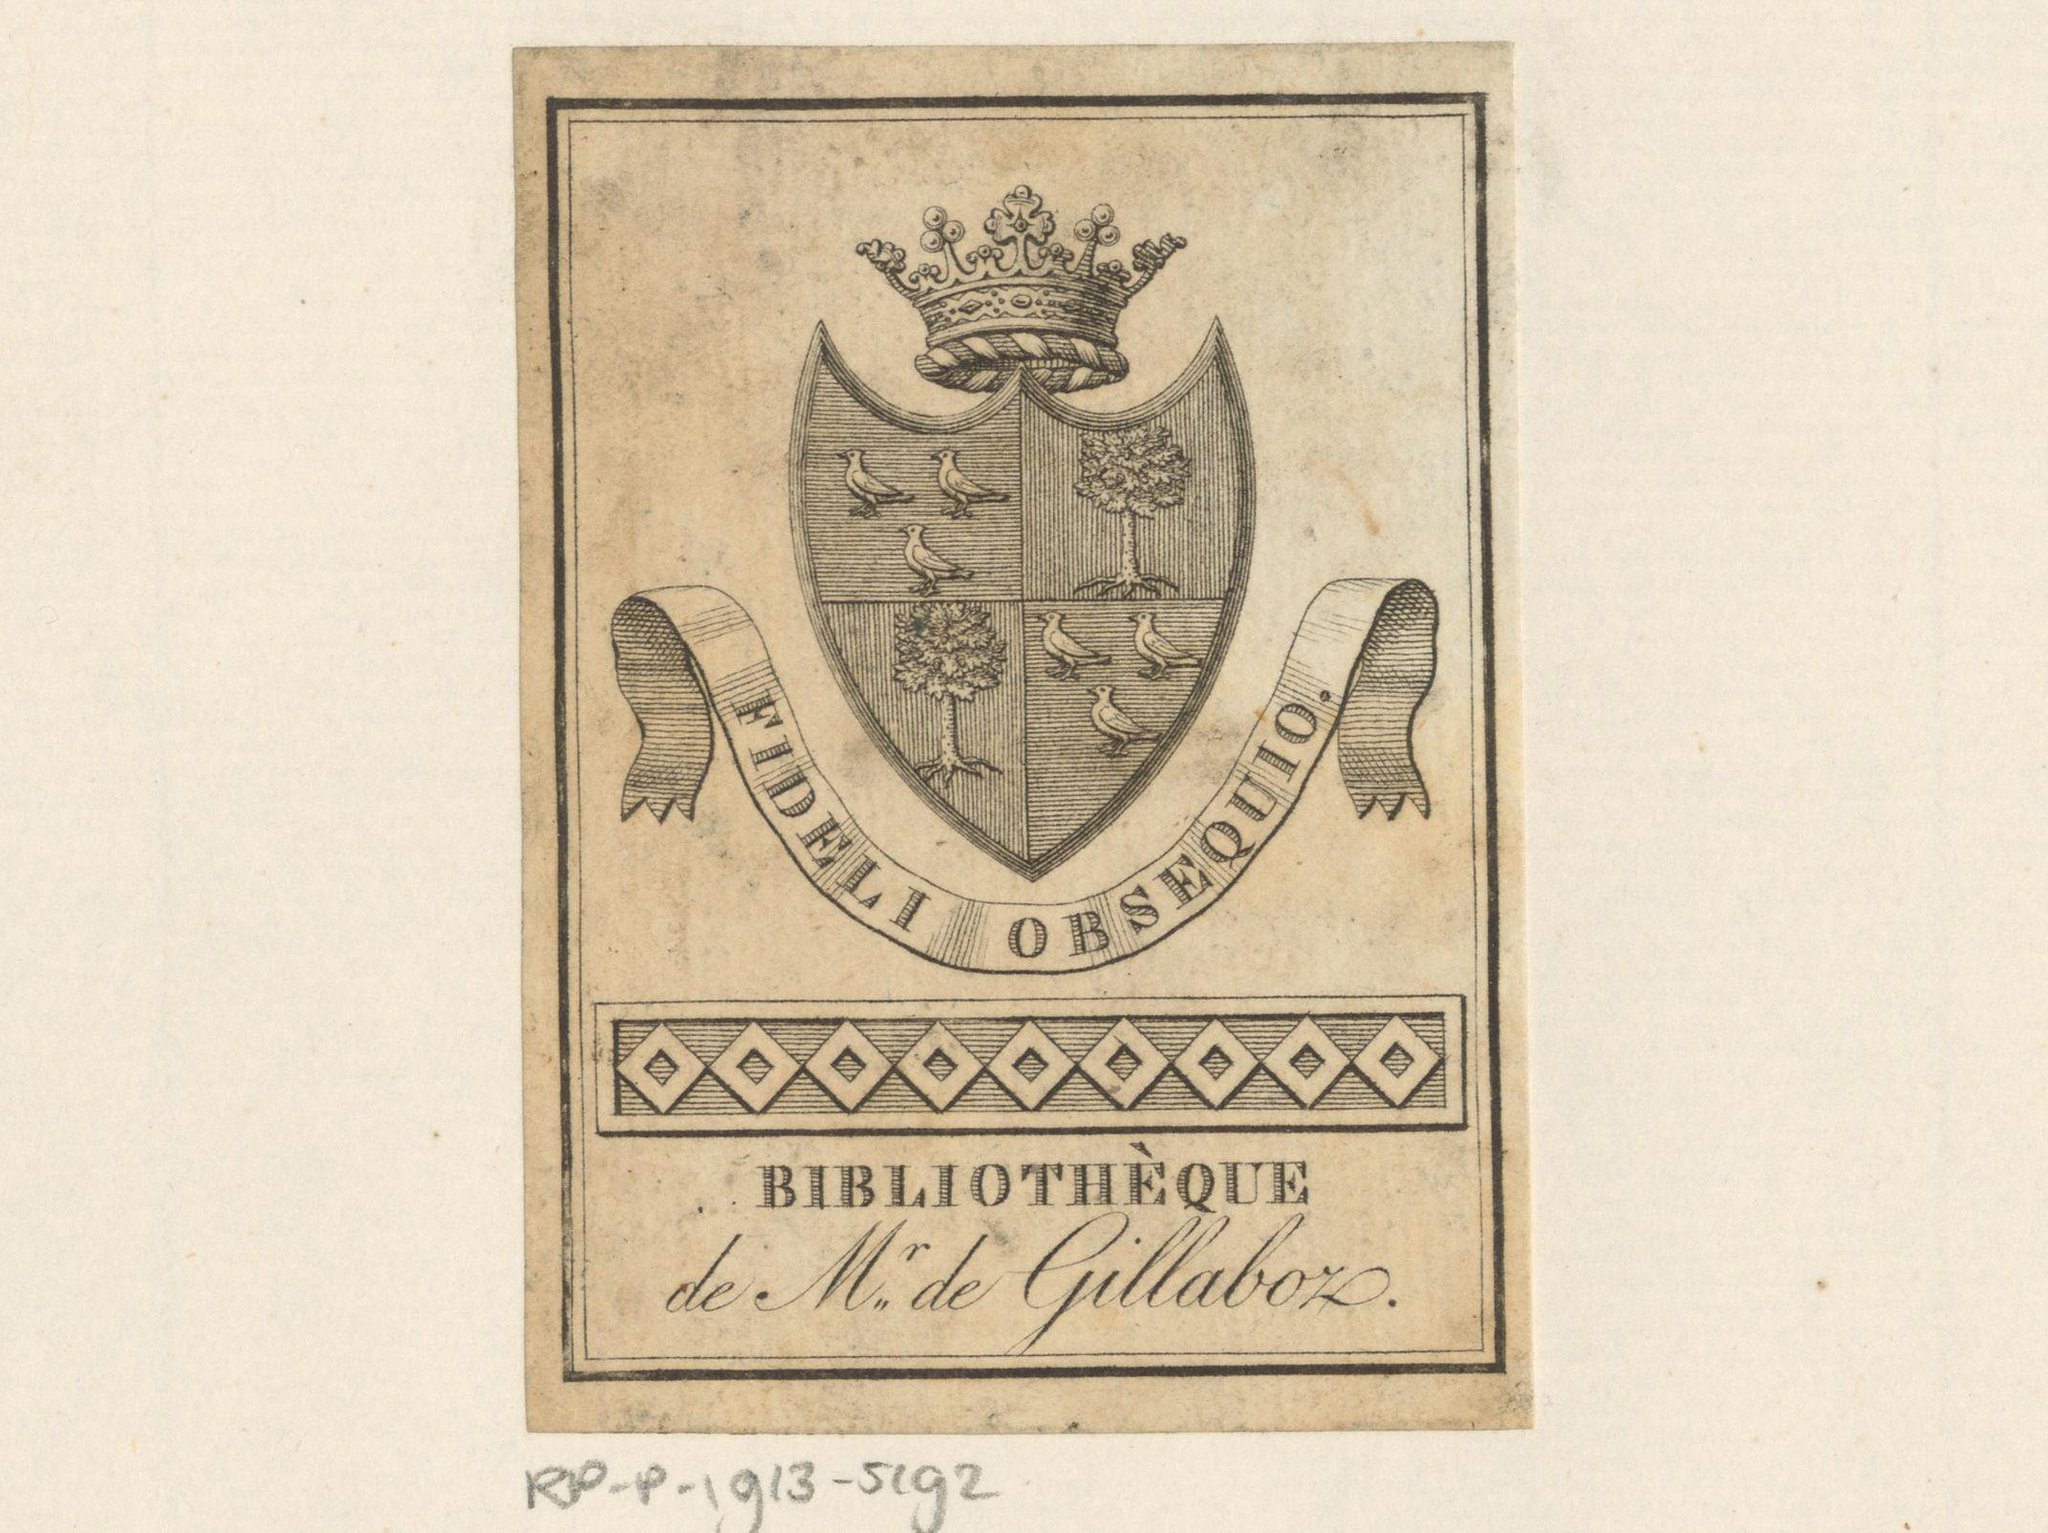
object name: bookplate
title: Fideli obsequio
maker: Anonymous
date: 1750-1849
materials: paper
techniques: engraving, etching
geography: belgium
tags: trees, birds, armorial bearing, heraldry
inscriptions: collector's mark: Lugt 2233, collector's mark: Lugt 2760